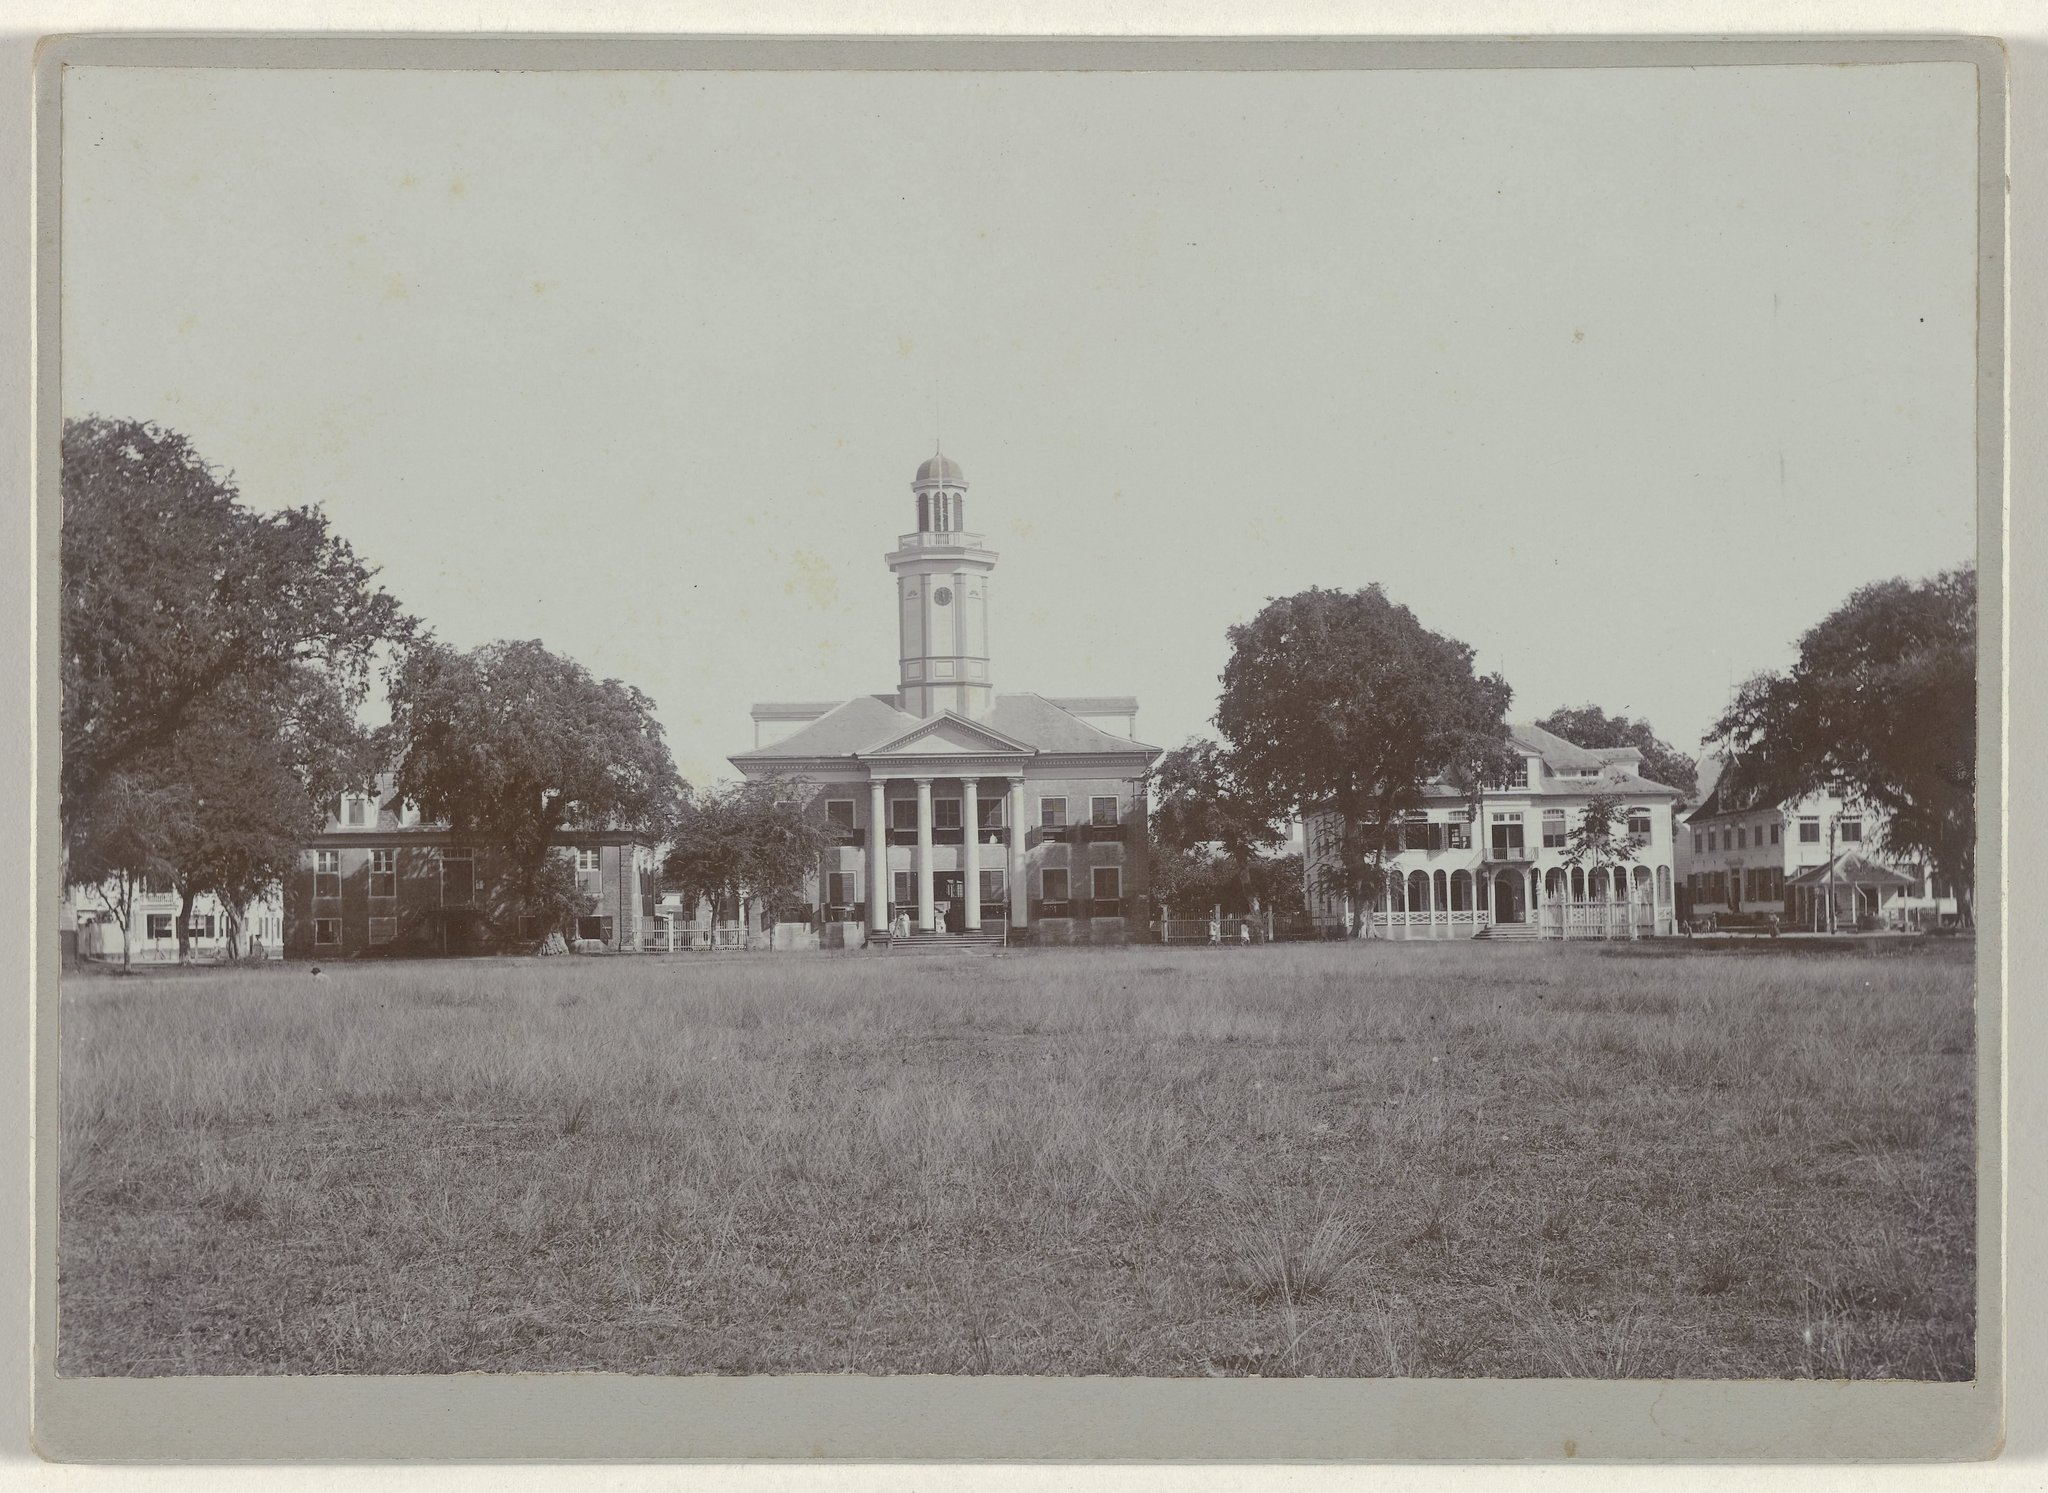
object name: photograph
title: Het Gouvernementsplein in Paramaribo met centraal het Departement van Financiën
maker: Anonymous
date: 1907-1908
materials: cardboard, photographic support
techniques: photography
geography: paramaribo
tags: square, place, circus, etc.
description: Gouvernementsplein met het Hof van Justitie, het Departement van Financiën met Nederlandse vlag en de Secretarie. Onderdeel van een groep foto's van de familie Boom-Gonggrijp in Suriname.